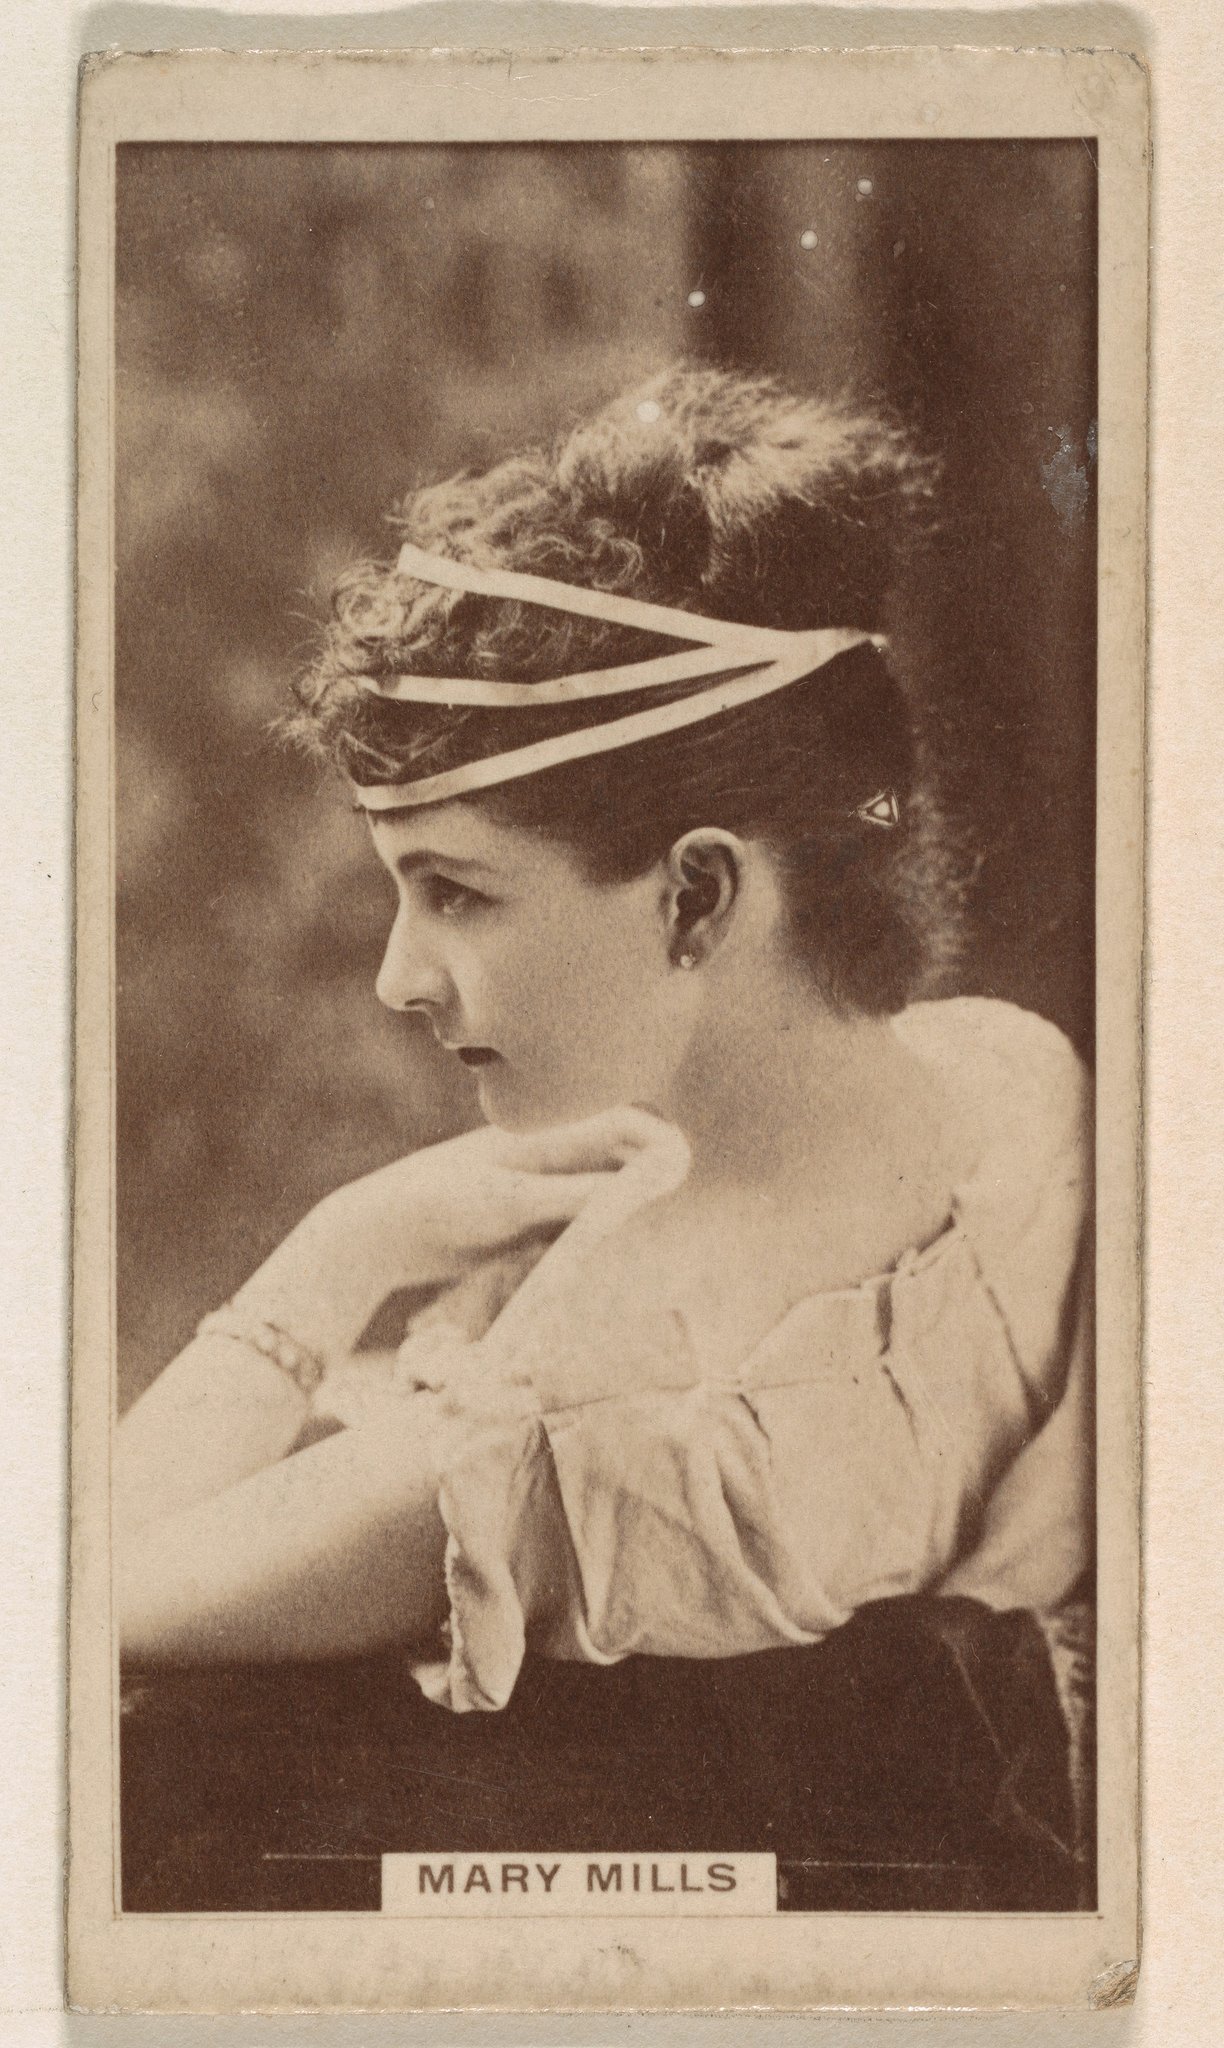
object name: photograph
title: Mary Mills, from the Actresses series (N245) issued by Kinney Brothers to promote Sweet Caporal Cigarettes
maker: kinney brothers tobacco company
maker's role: publisher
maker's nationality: american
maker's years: 1869-2011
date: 1890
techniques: albumen silver print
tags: women,actresses